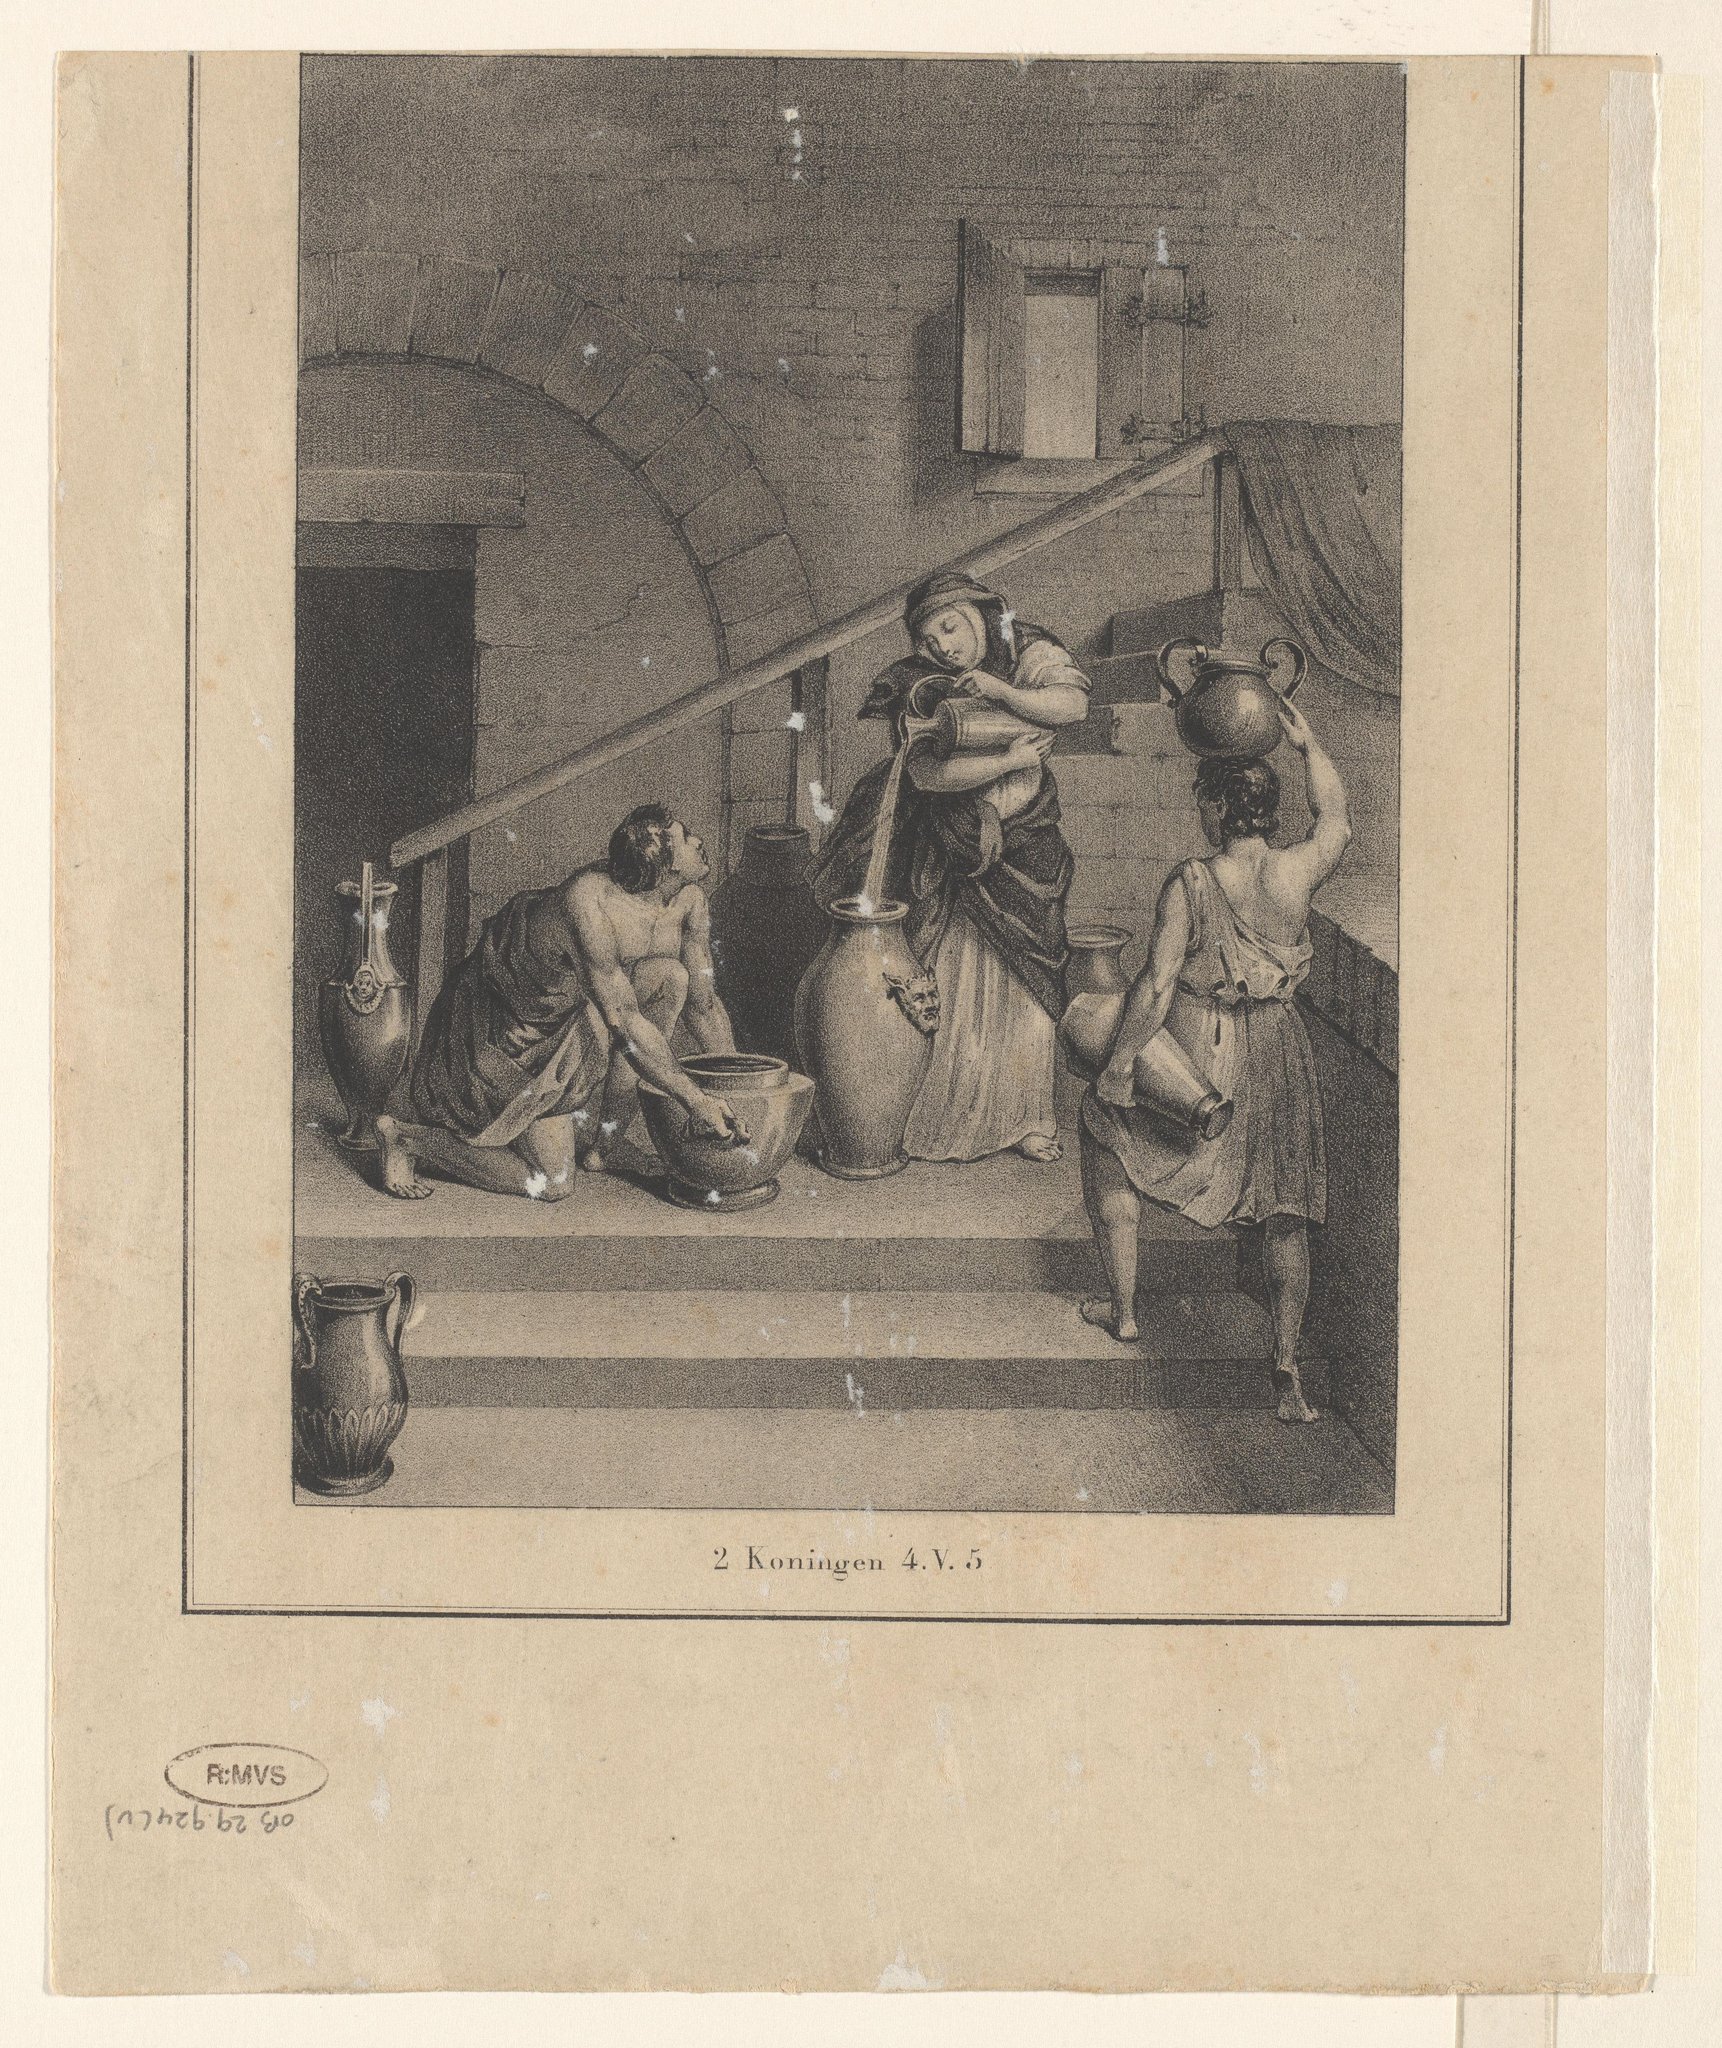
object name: print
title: 2 Koningen 4.V.5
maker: Anonymous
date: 1833-1842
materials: paper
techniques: lithograph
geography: netherlands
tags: the widow's oil: the little oil a woman has in store increases so that she and her son are able to fill many borrowed jars with it (2 kings 4:1-7)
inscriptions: collector's mark: Lugt 2228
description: In opdracht van Elisa giet een arme weduwe het laatste beetje olie dat zij heeft in zoveel mogelijk kruiken. Haar twee zoons komen met nieuwe lege kruiken aan die de weduwe kan vullen en verkopen om haar schulden af te betalen.